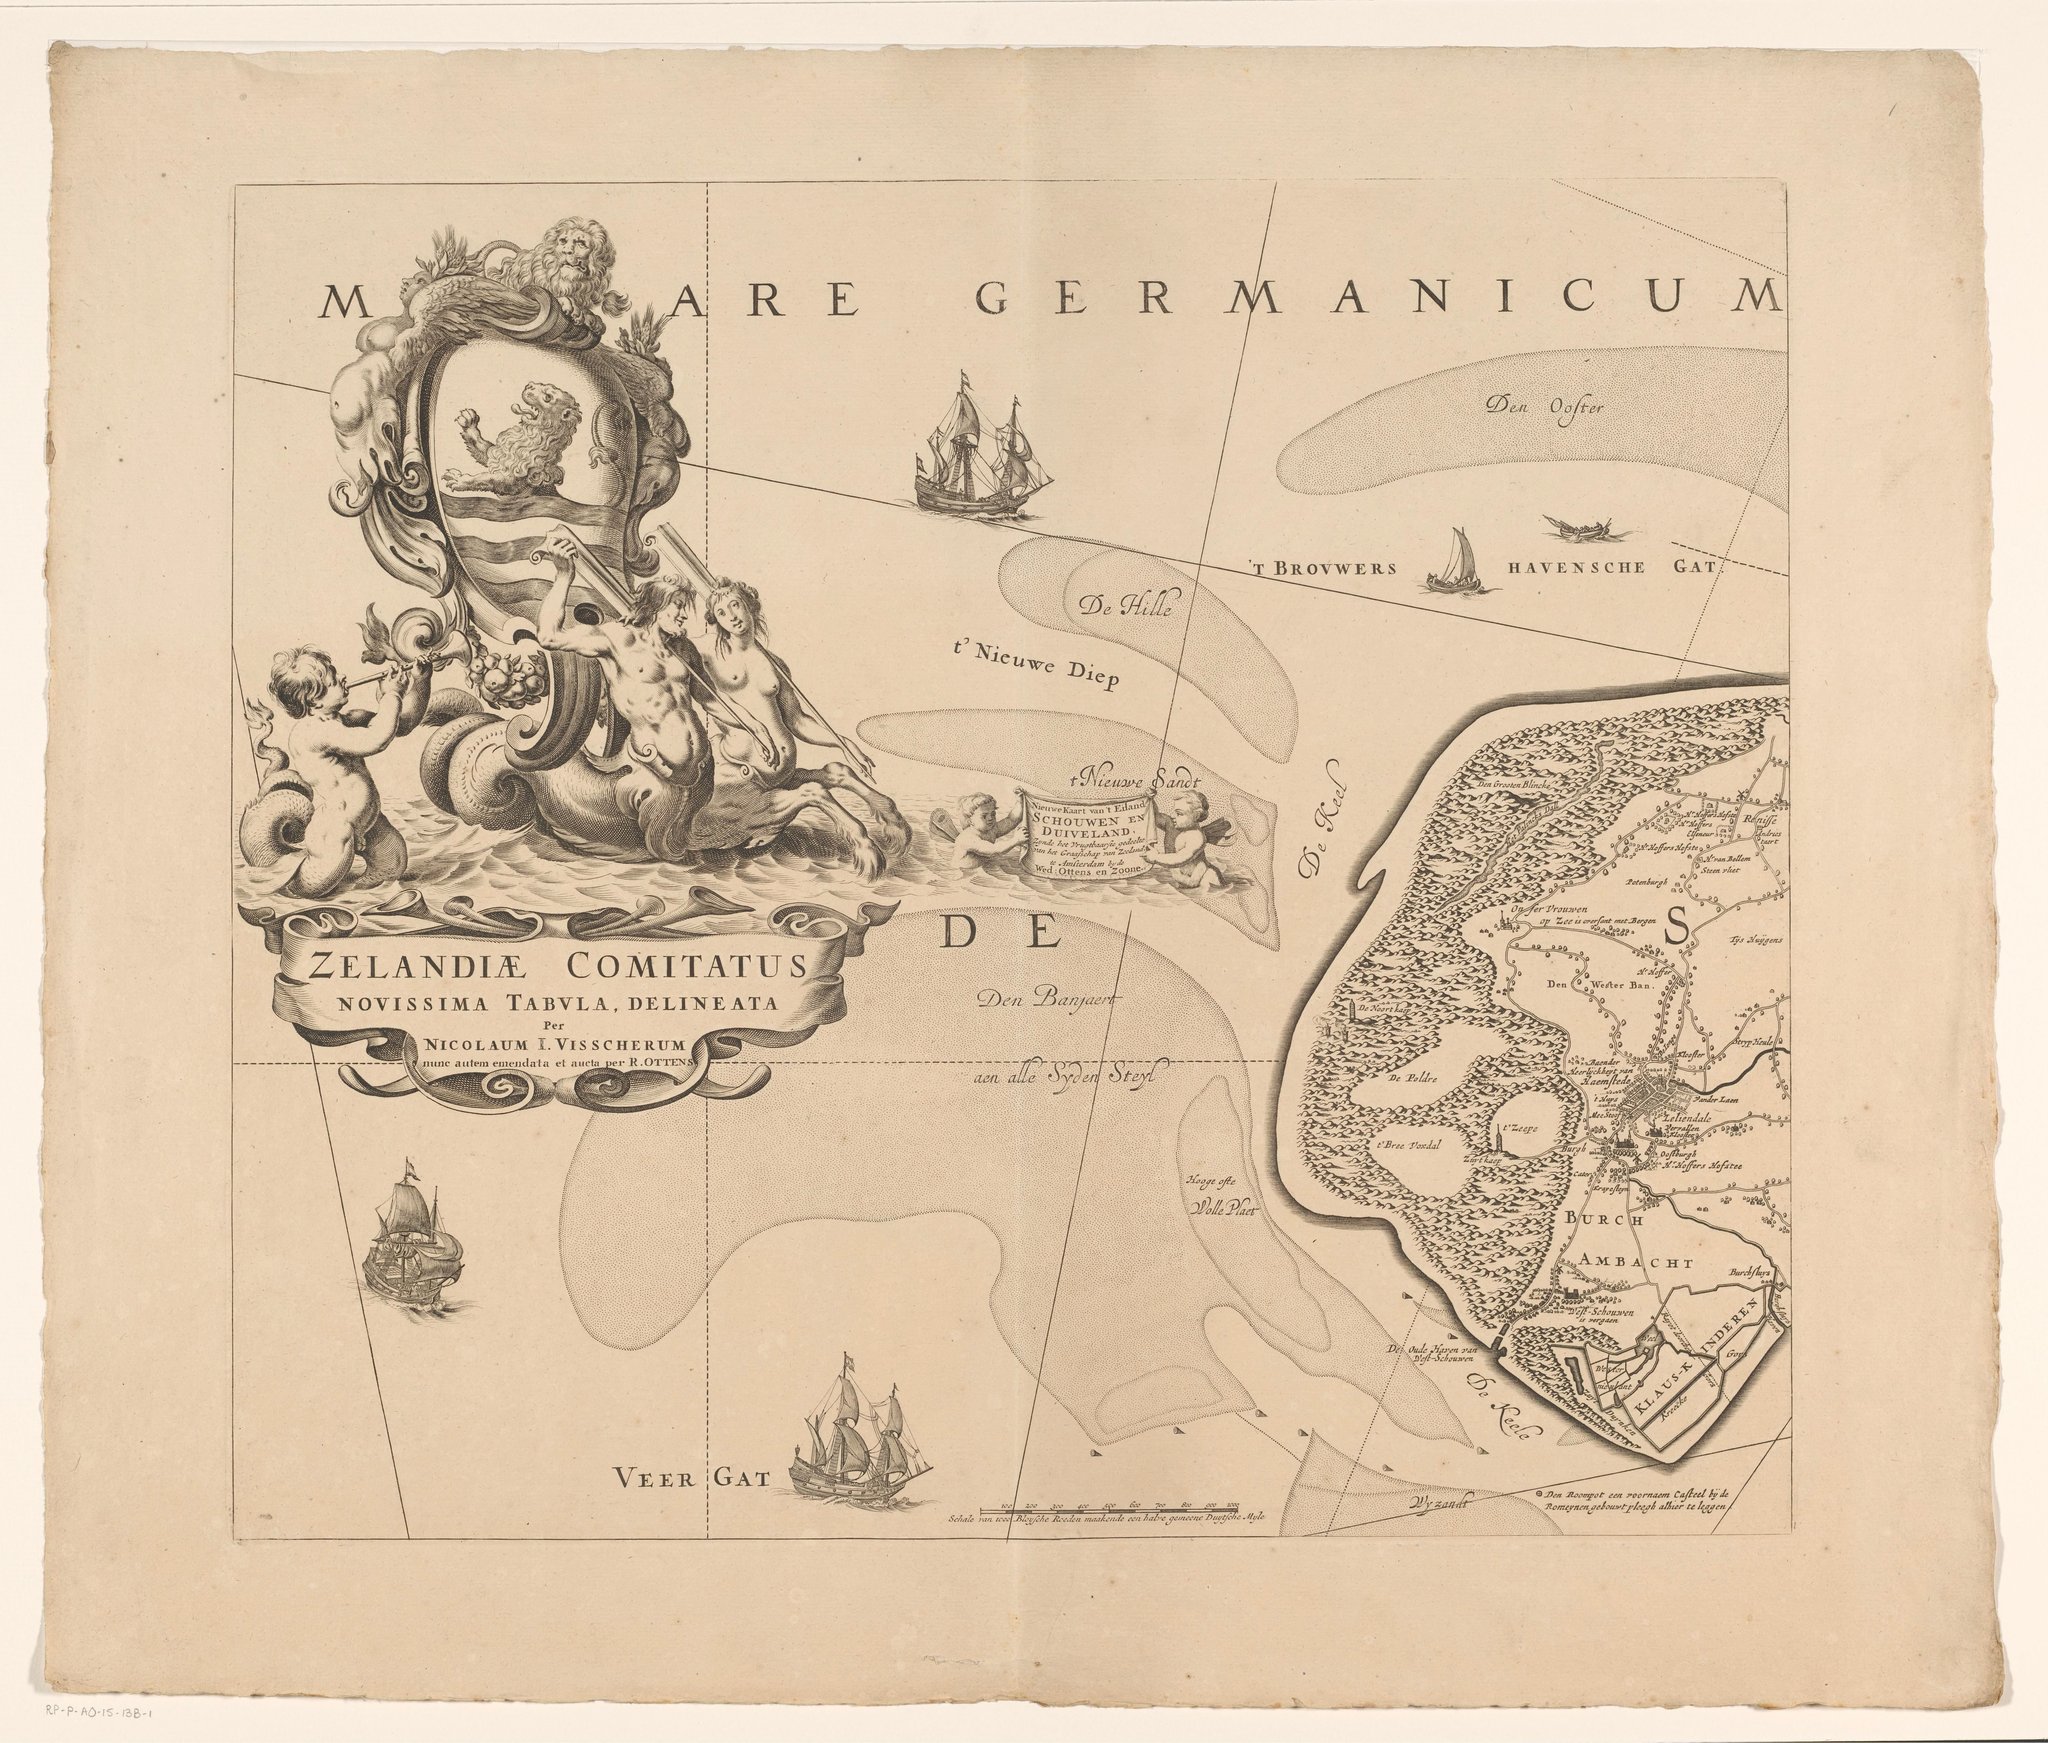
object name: print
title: Kaart van Zeeland (eerste deel)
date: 1655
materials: paper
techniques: engraving, etching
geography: amsterdam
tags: triton(s), maps of separate countries or regions, coat of arms (as symbol of the state, etc.) (+ province; provincial), ichthyocentaur, centaurotriton, sea-centaur, zeeland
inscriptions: collector's mark: Lugt 19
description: Eerste deel van een kaart van Zeeland, bestaande uit negen delen. Rechtsonder genummerd: 1.